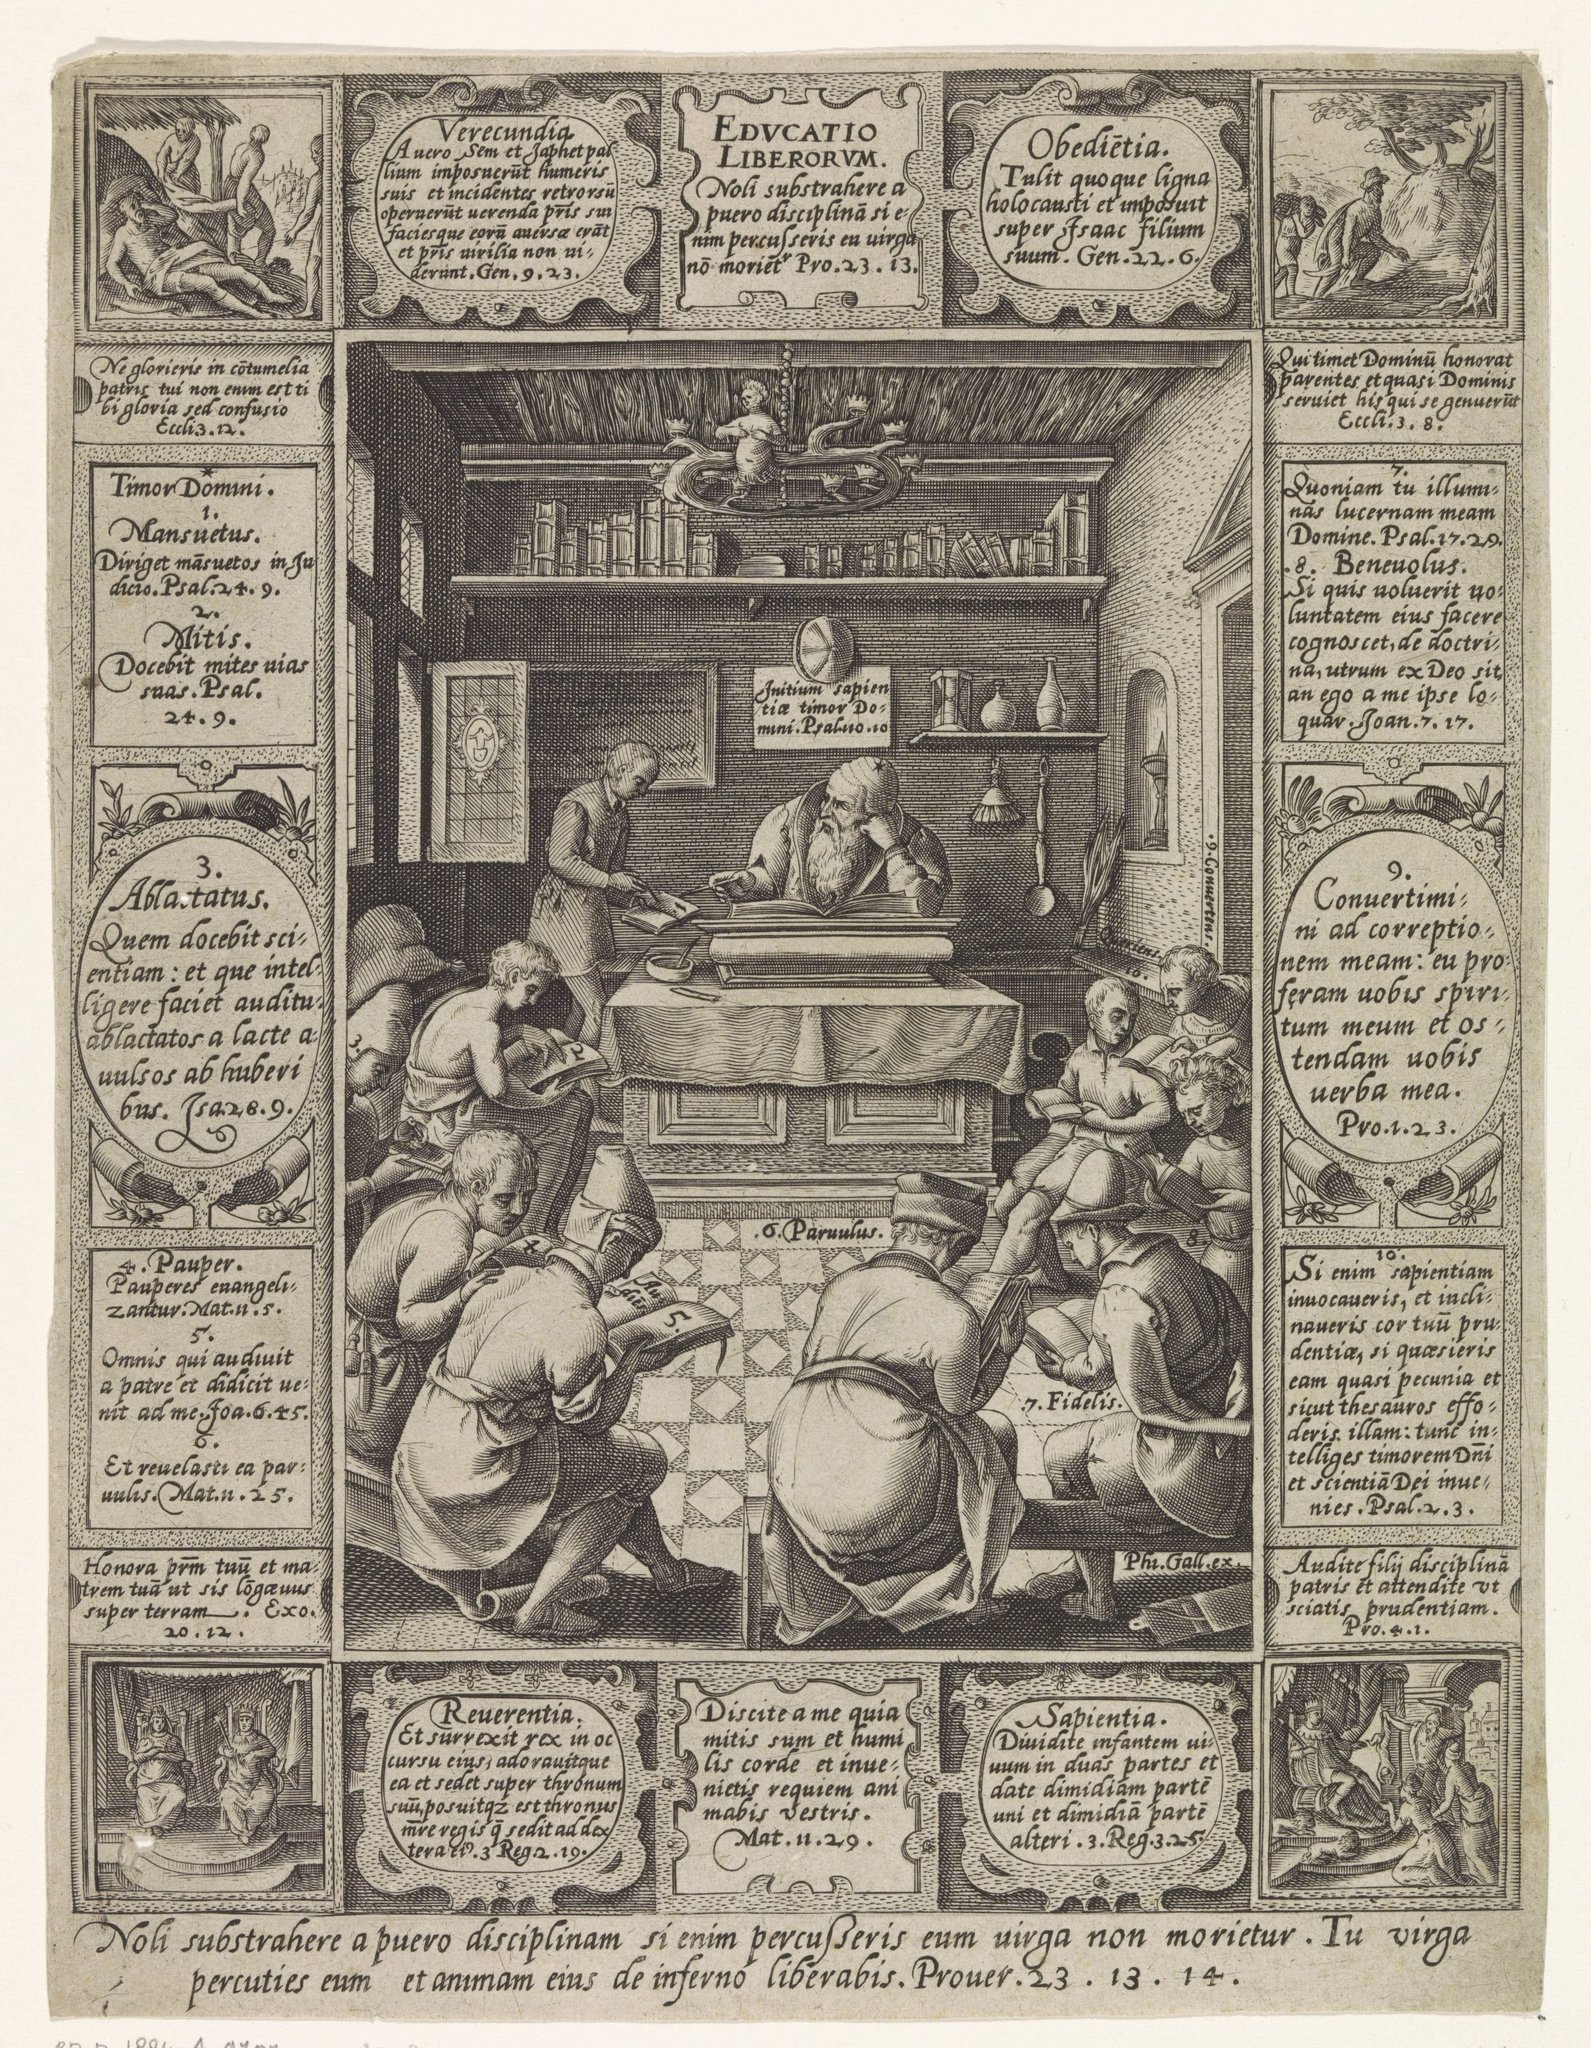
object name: print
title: Opvoeding van kinderen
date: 1578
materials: paper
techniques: engraving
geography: haarlem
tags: elementary school; class, form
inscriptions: collector's mark: Lugt 2228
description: Allegorie met centrale voorstelling van leraar die zijn leerlingen onderwijst en daaromheen een omlijsting waarin citaten uit de bijbel gecombineerd zijn met de verbeelding van bepaalde gebeurtenissen uit de bijbel. In de marge onderaan twee regels bijbeltekst in Latijn